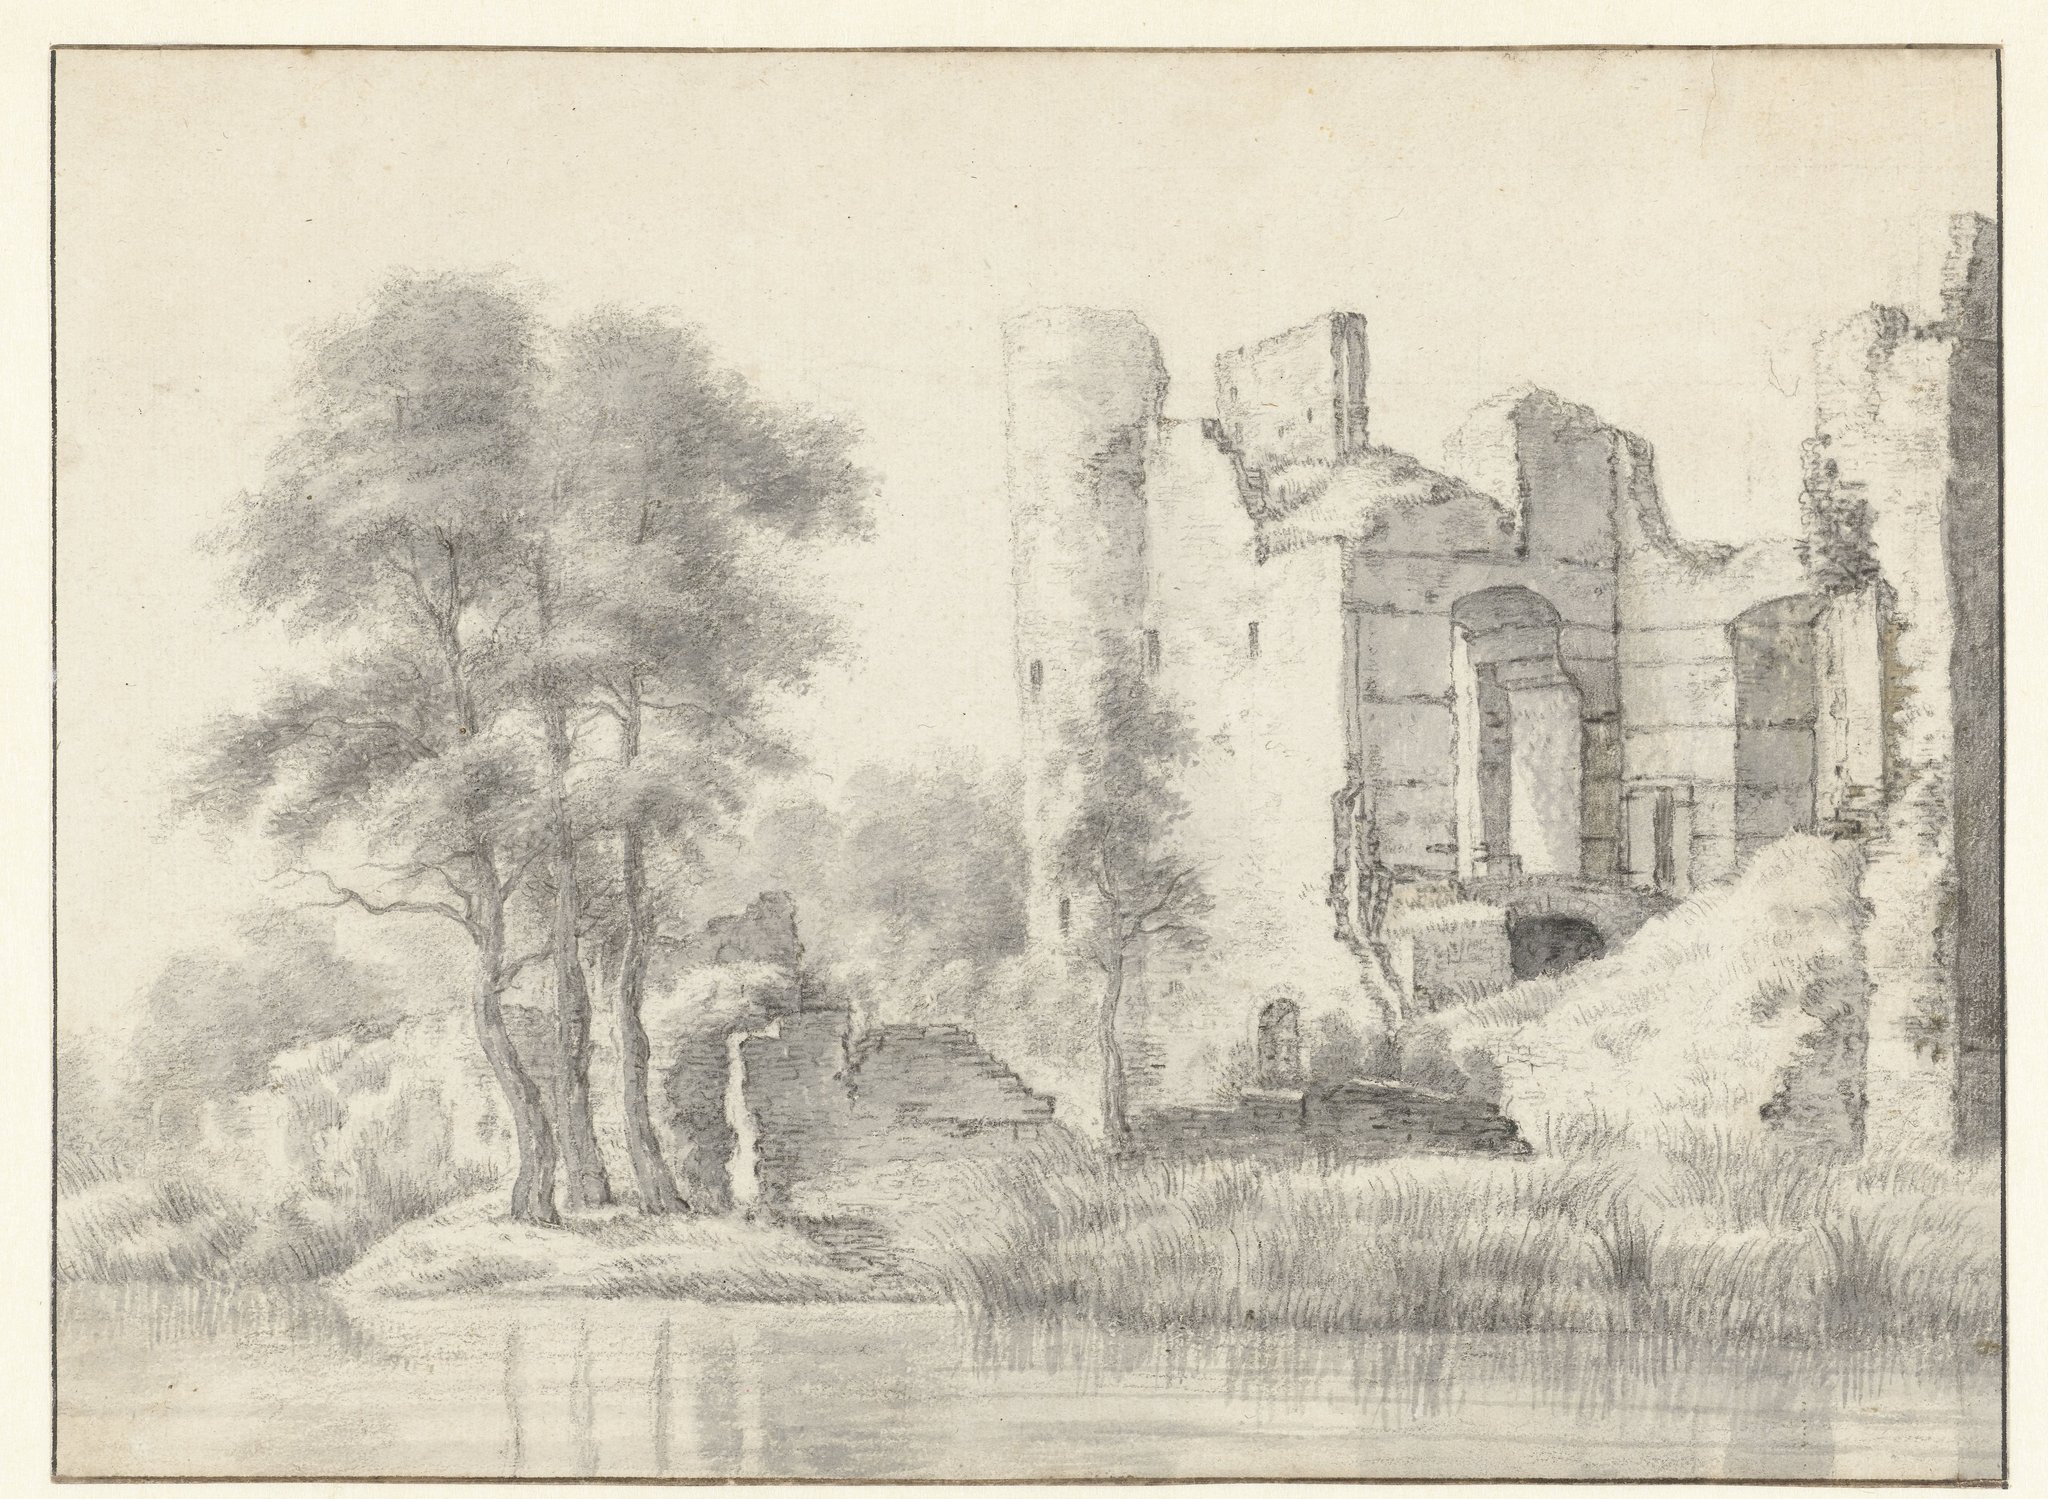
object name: drawing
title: View of the Ruins of Kasteel te Heenvliet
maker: roelant roghman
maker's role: draughtsman, painter, print maker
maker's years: 1627-1692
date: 1646-1647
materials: chalk, paper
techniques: brush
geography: heenvliet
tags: castle, ruin of a building ~ architecture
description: Voor prent gebaseerd op deze tekening zie RP-P-AO-14-111.